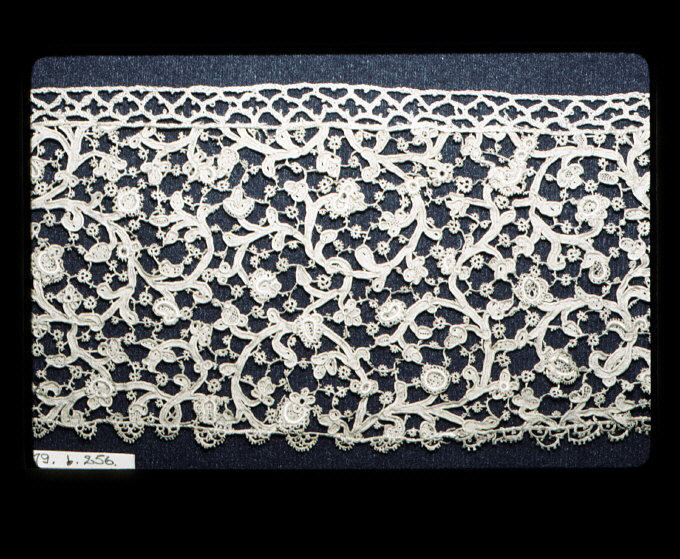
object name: strip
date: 1700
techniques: lace